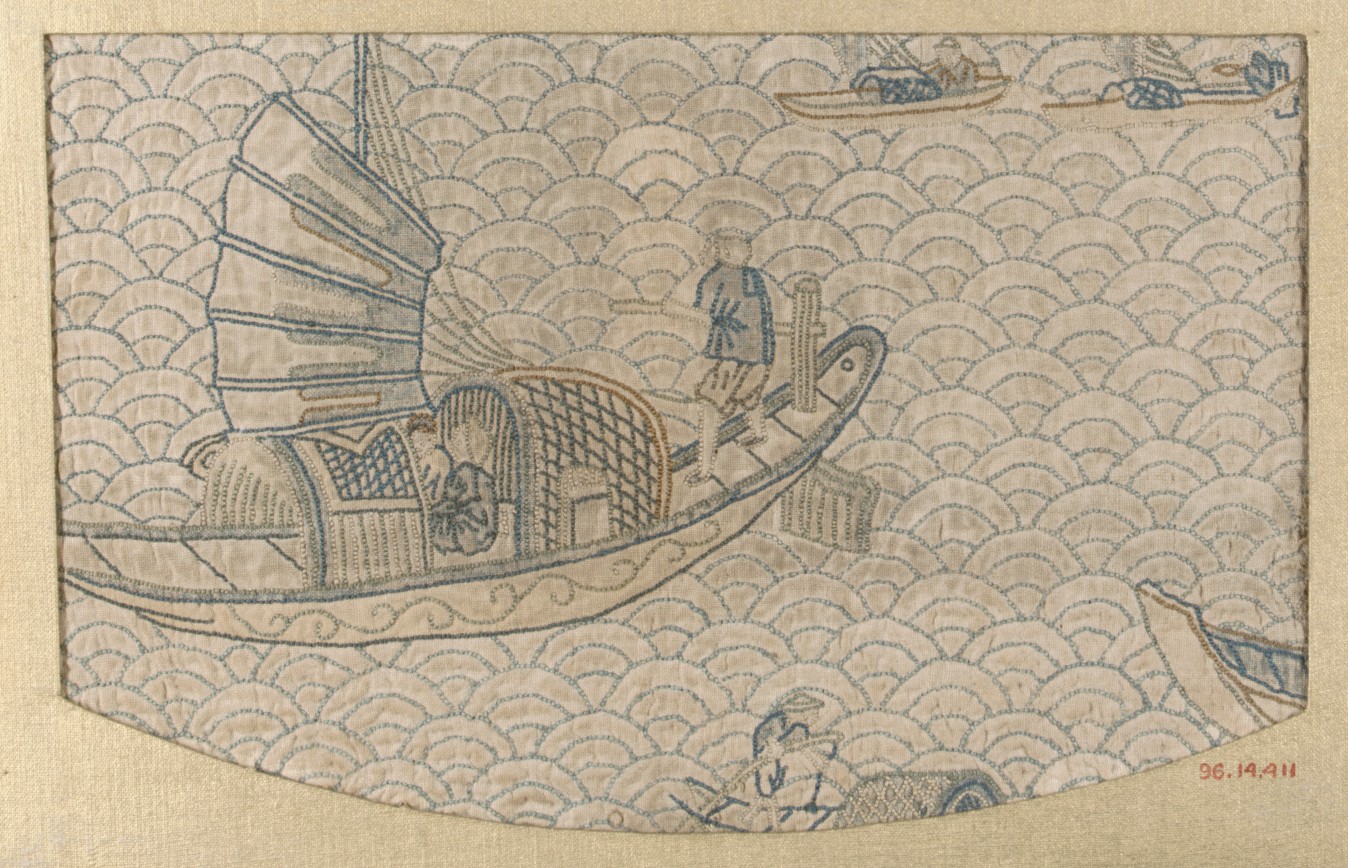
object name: piece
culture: japanese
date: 1701-1900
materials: silk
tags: men